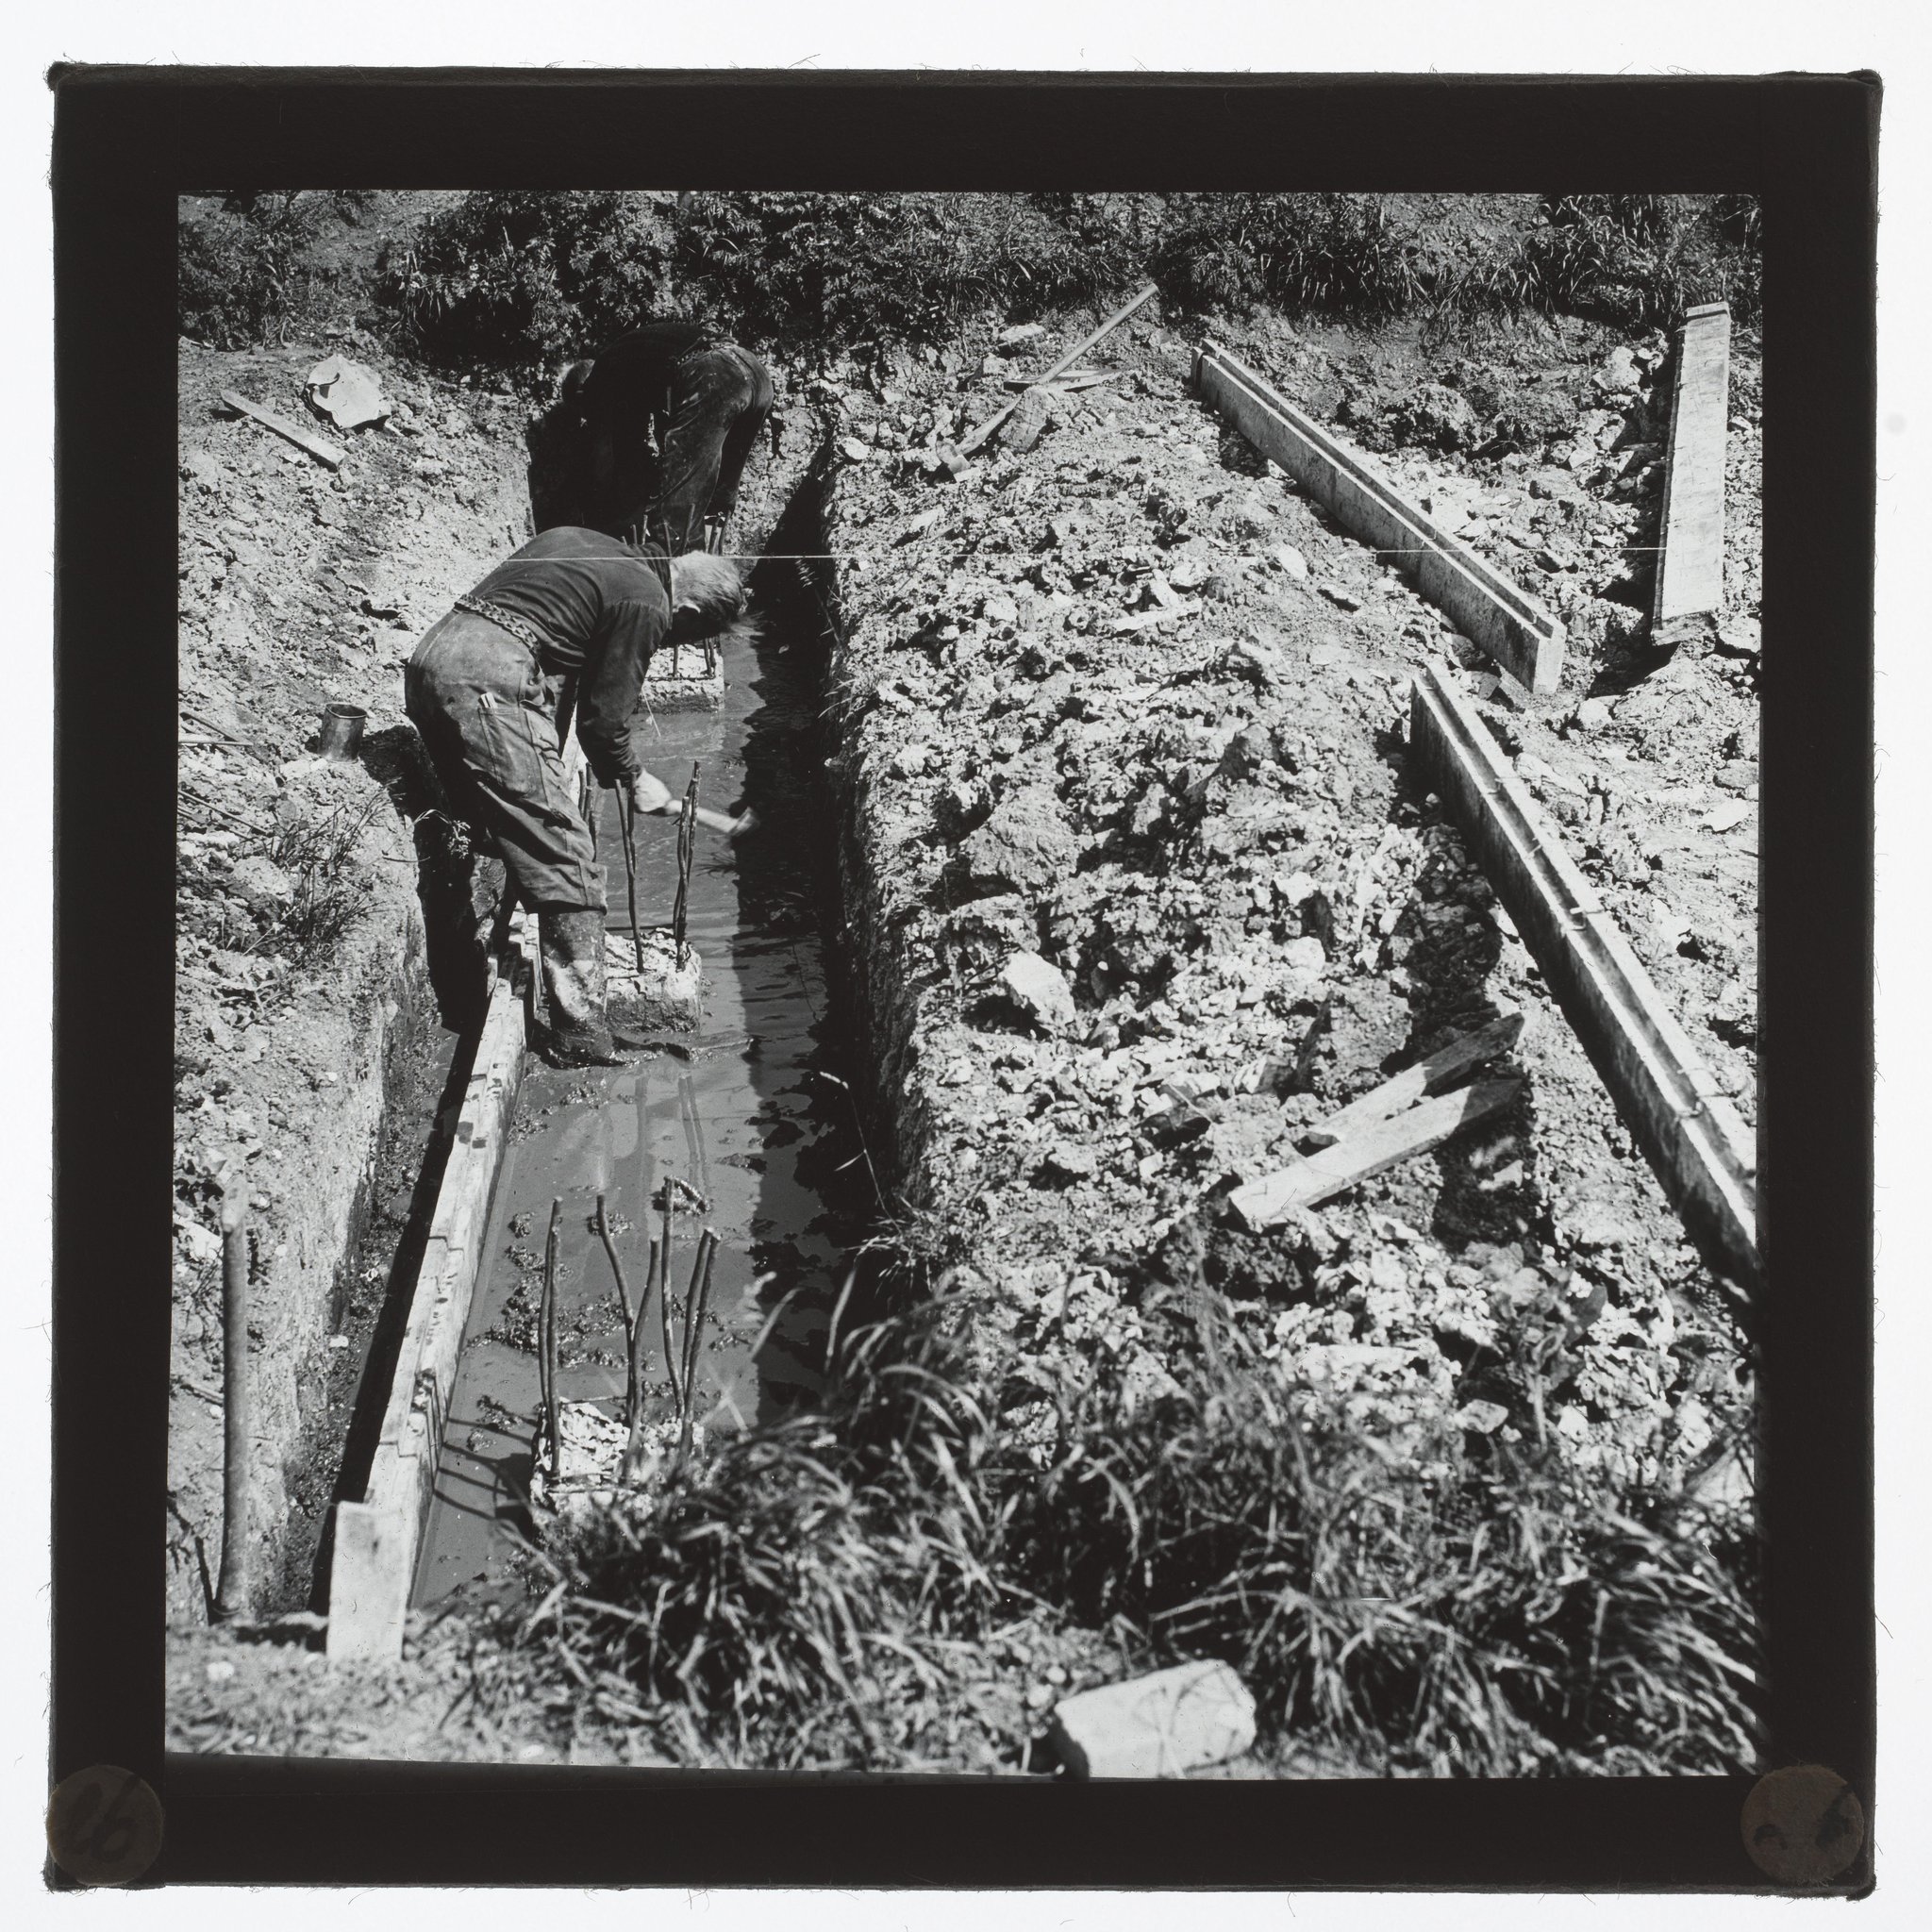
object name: lantern slide photographic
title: Betonvlechters aan het werk, Zuid-Holland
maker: Anonymous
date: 1956-1960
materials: glass, paper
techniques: gelatin silver transparency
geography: south holland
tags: building-site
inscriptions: number: ‘26’